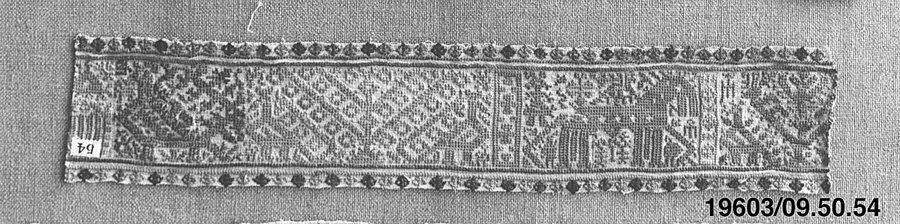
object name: band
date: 1601-1800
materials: linen, silk